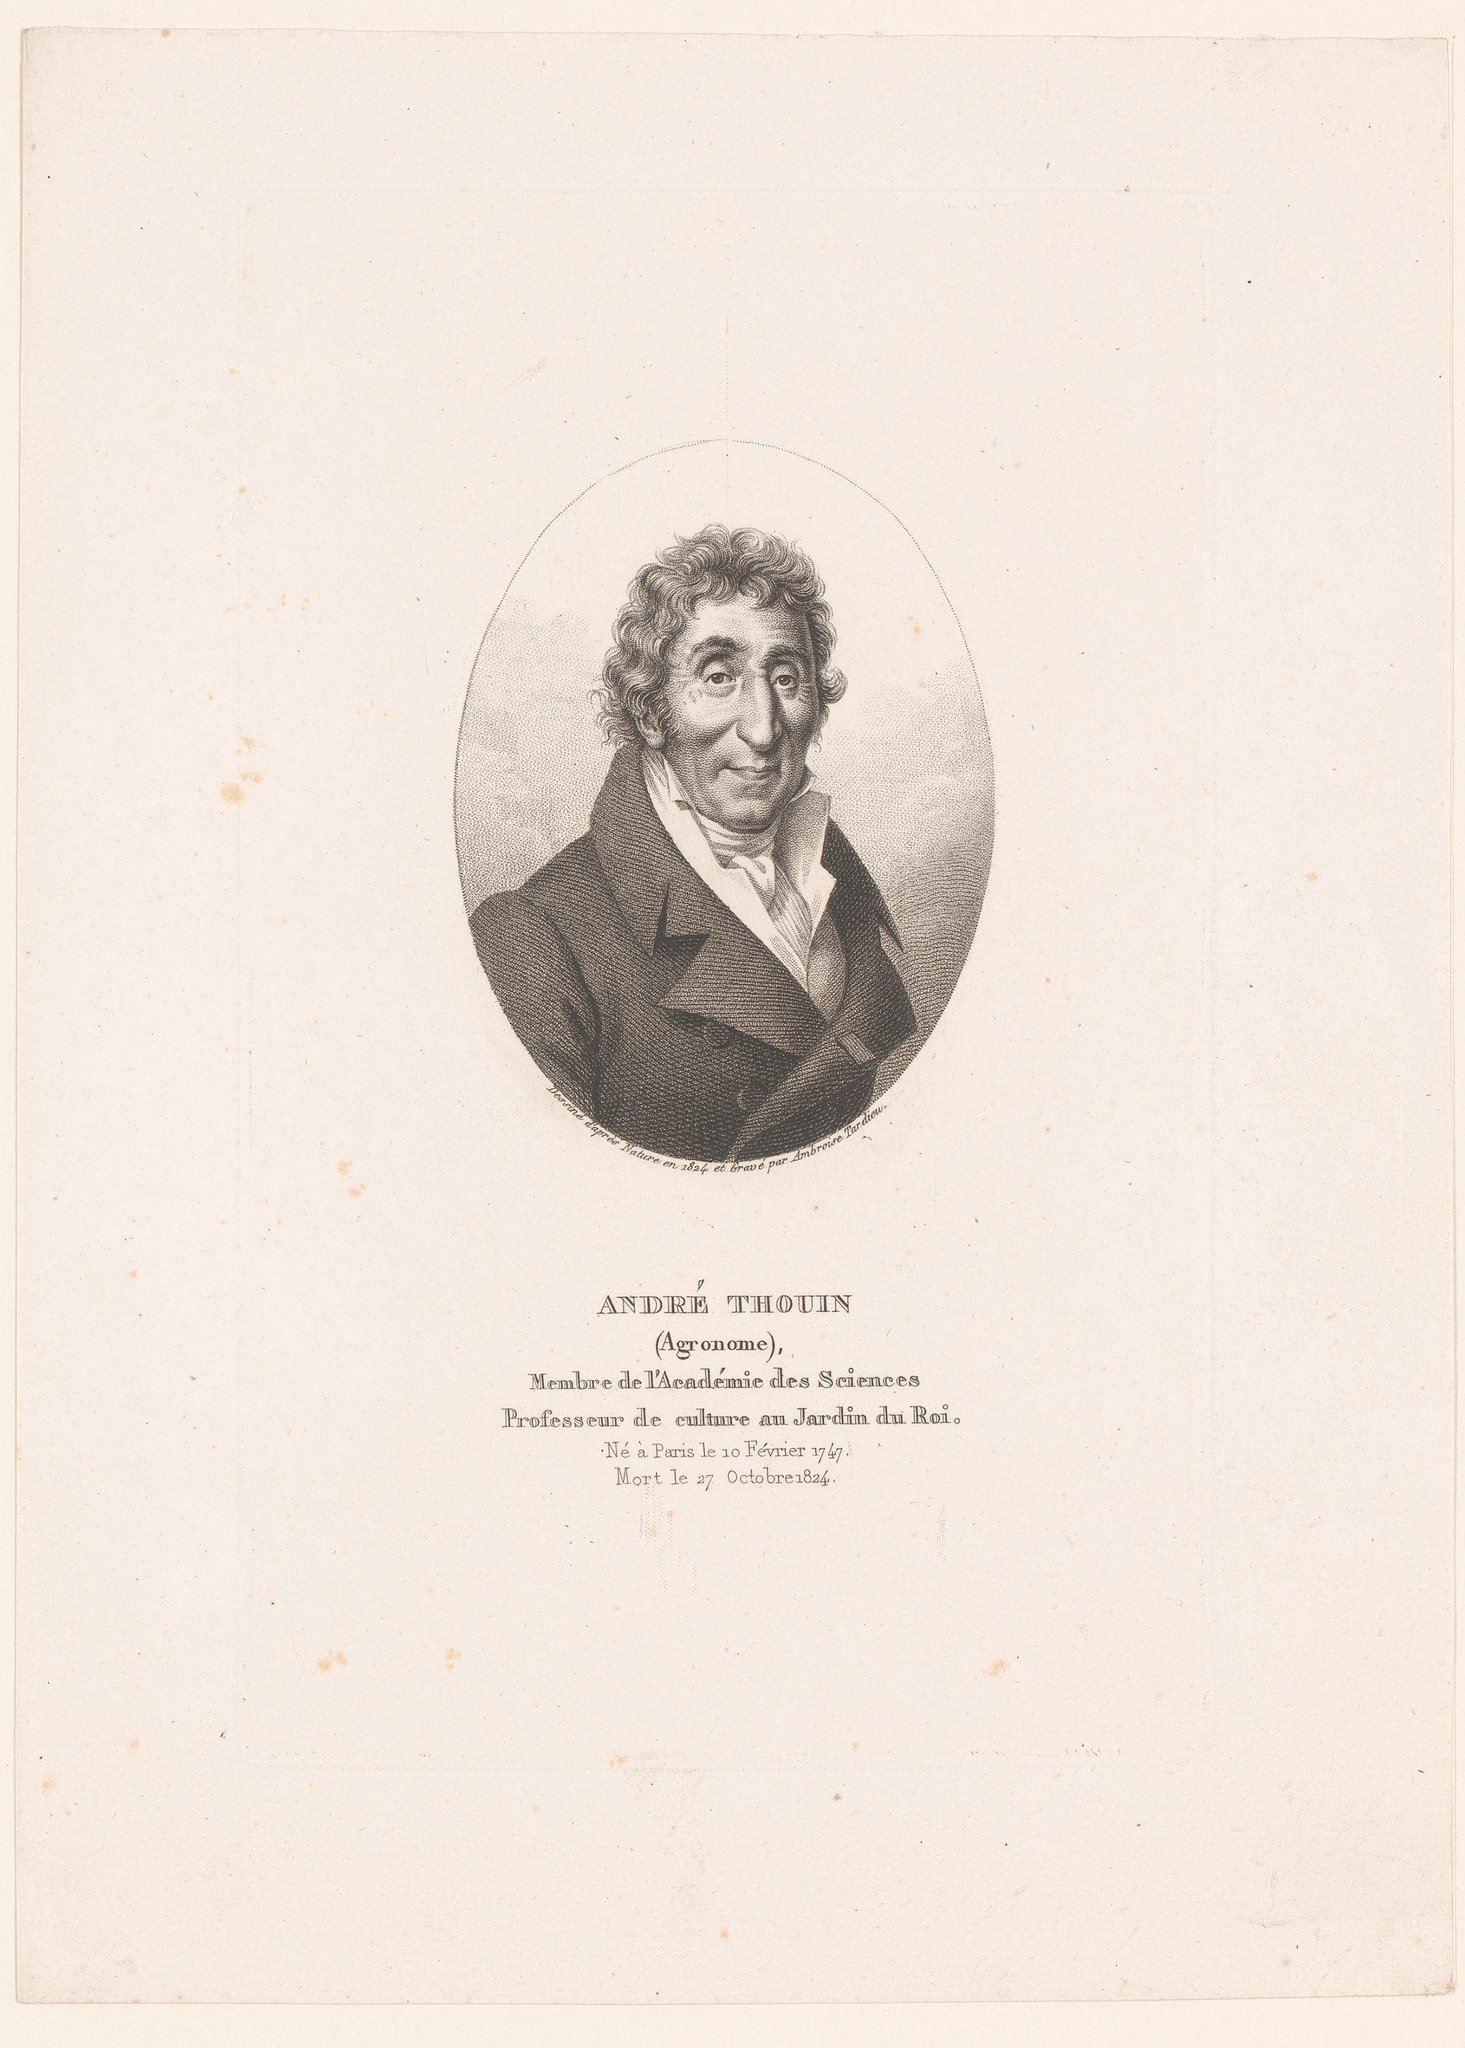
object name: print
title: Collection de tous les personnages célèbres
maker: ambroise tardieu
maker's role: print maker, printer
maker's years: 1788-1841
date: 1824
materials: paper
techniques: engraving, roulette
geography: paris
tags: paris, historical persons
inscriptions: collector's mark: Lugt 2228